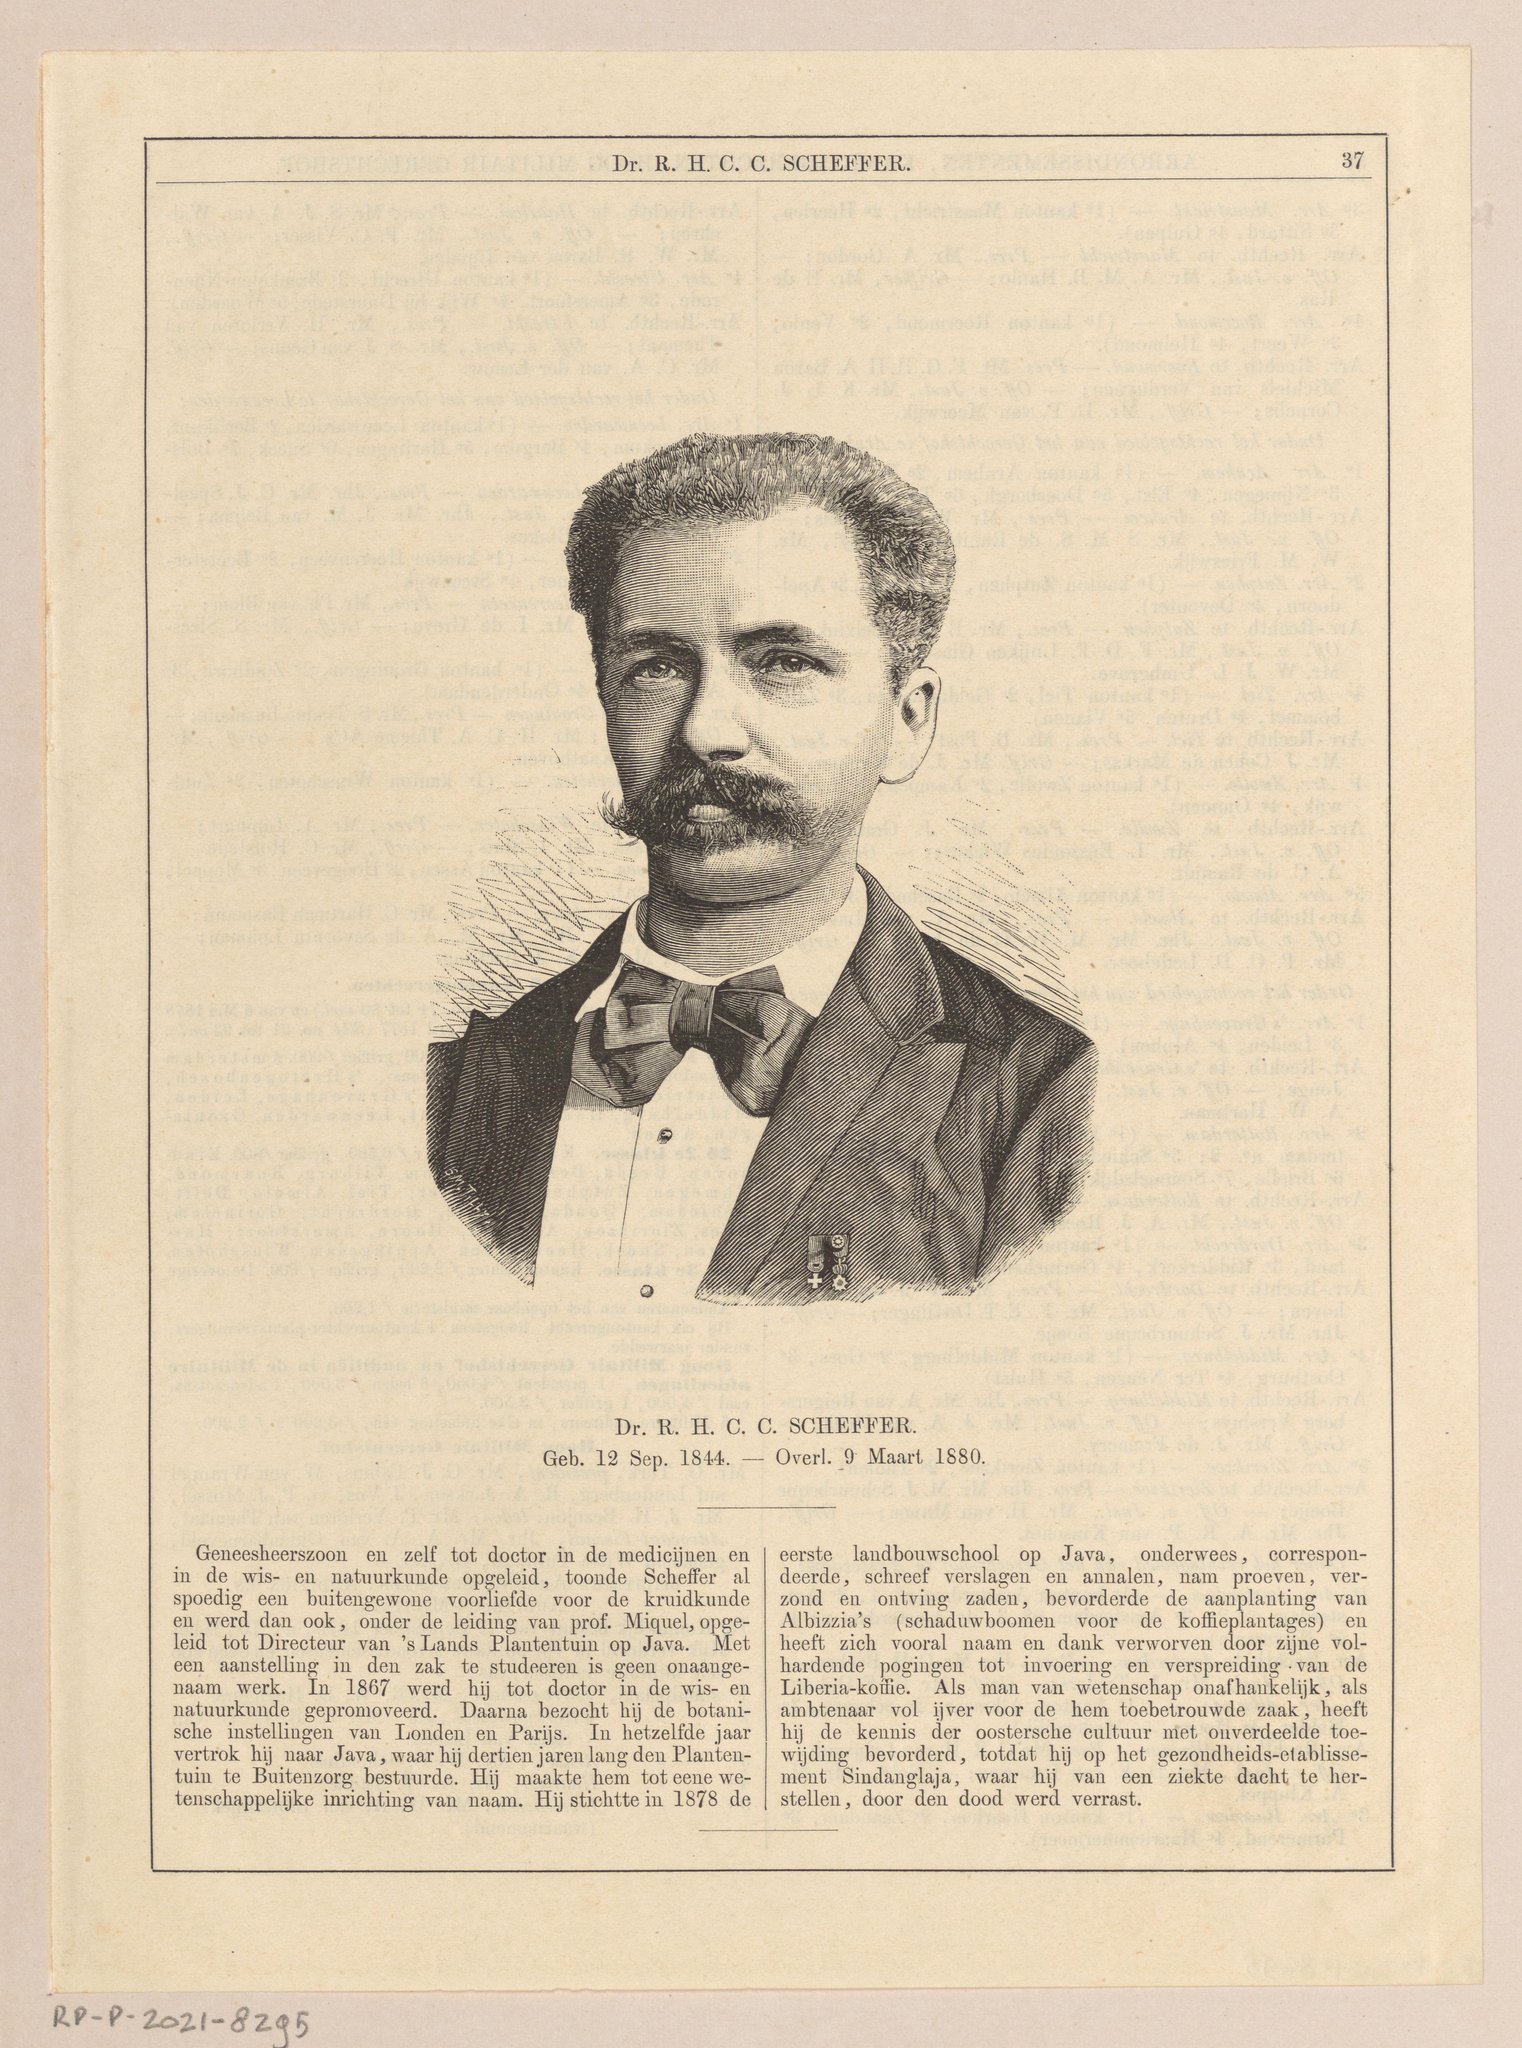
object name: print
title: Portret van Rudolph Scheffer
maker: hermanus diedericus tjeenk willink (1843-1917)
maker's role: publisher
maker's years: 1843-1917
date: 1880-1918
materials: paper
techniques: letterpress printing, engraving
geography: haarlem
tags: historical persons, physician, doctor